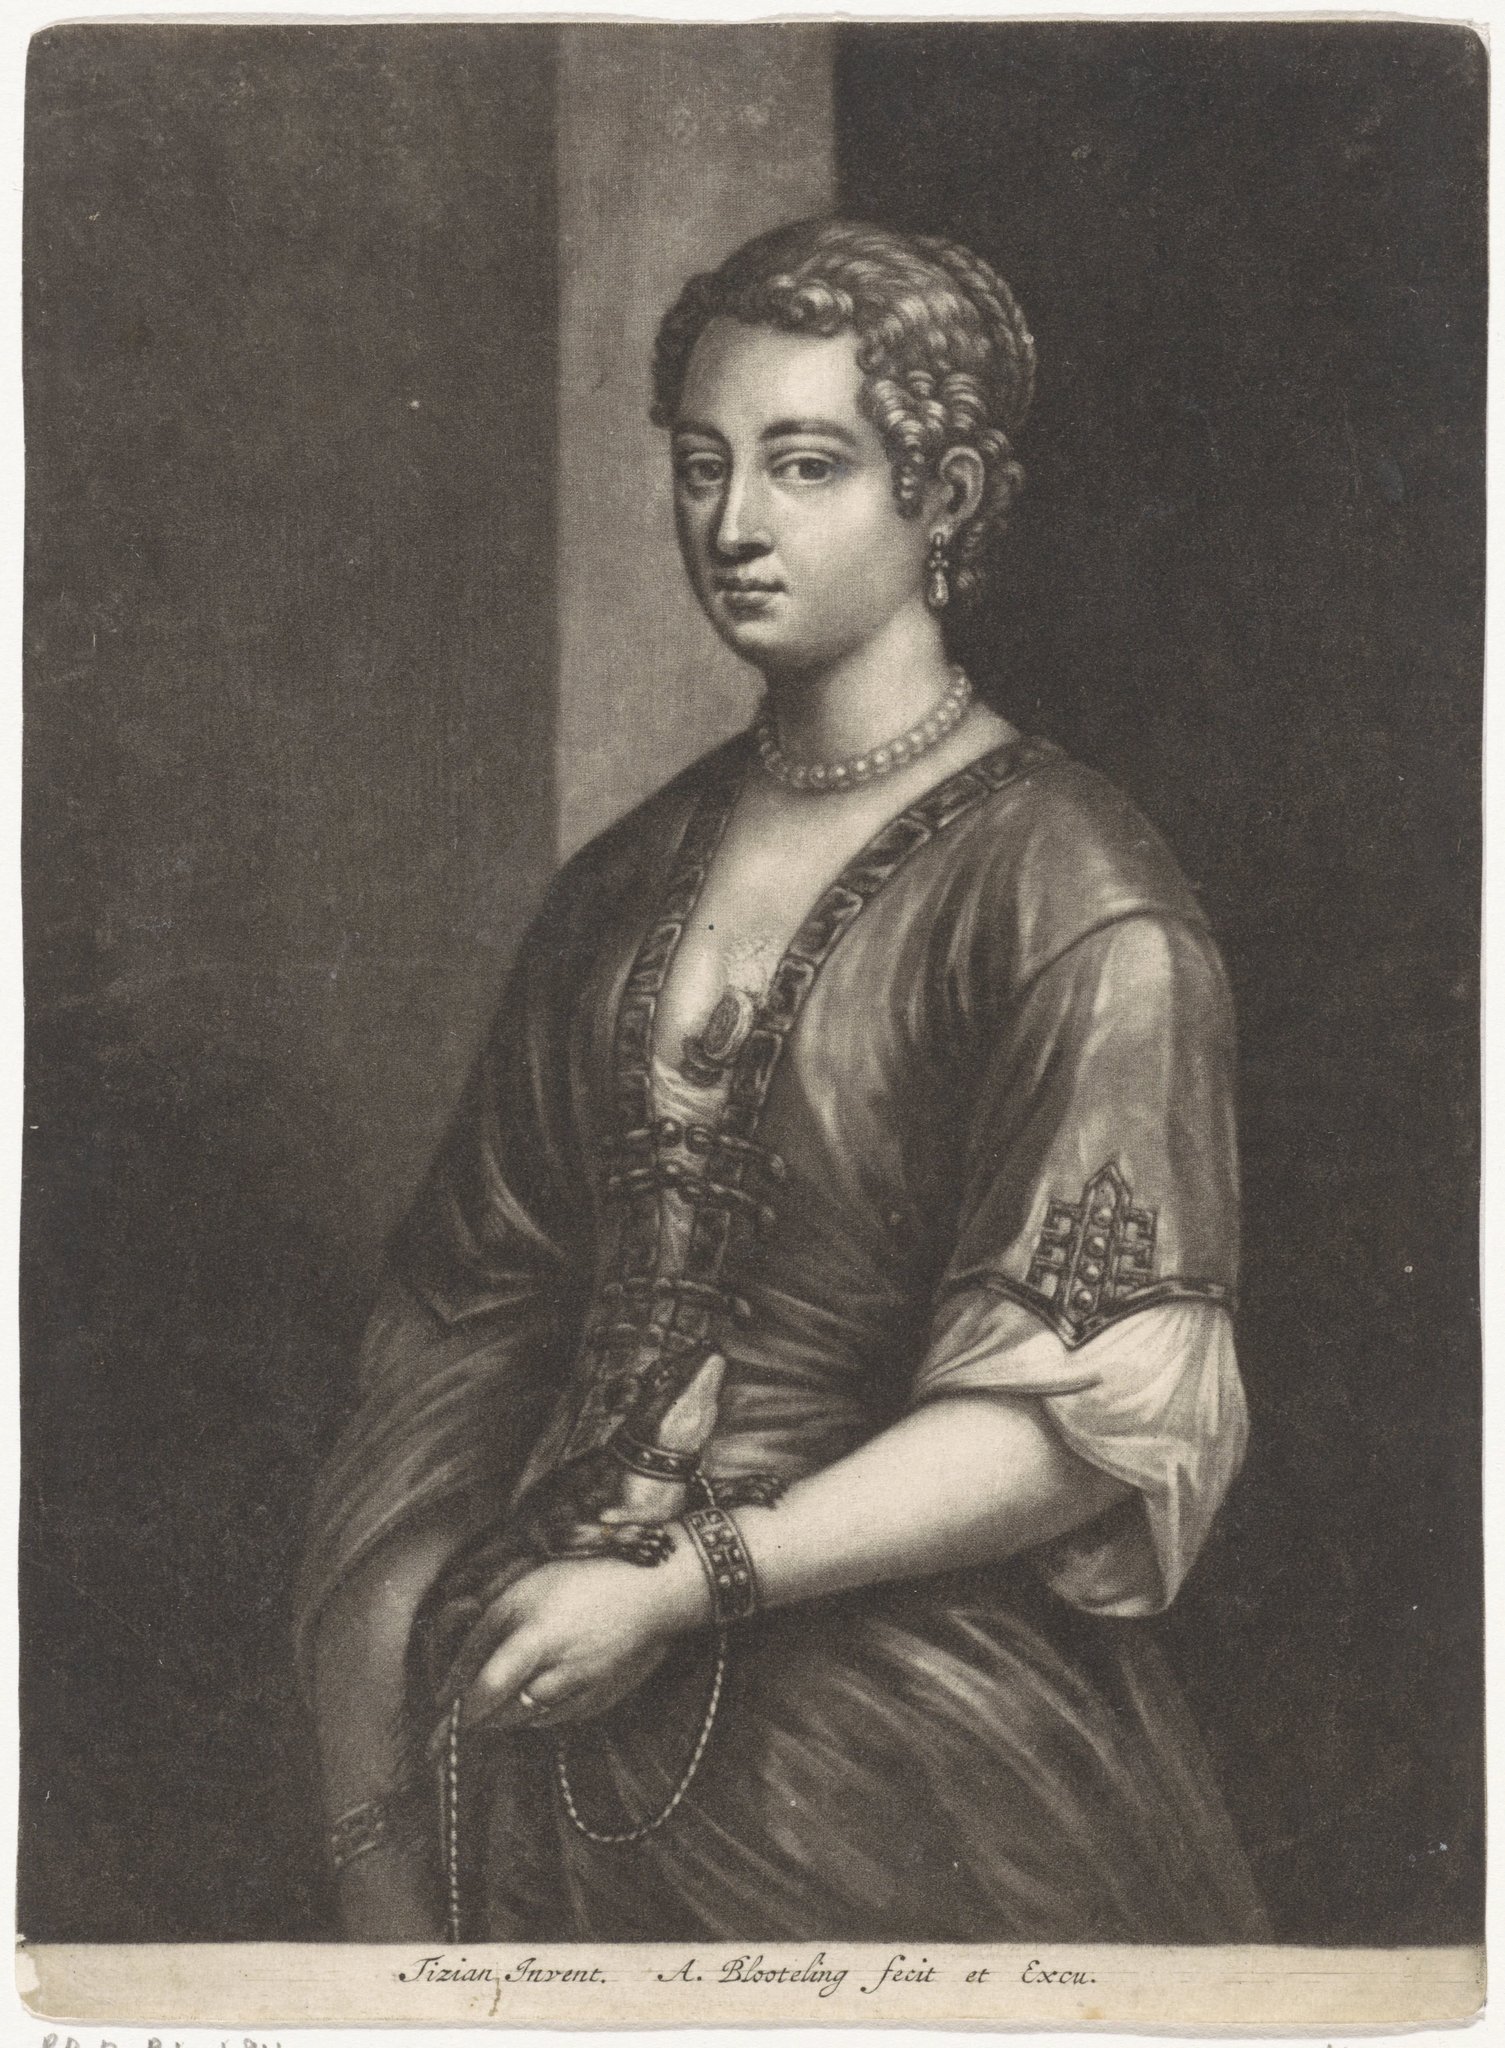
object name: print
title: Jonge vrouw met een hond op de arm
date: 1652-1690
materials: paper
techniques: engraving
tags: dog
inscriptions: collector's mark: Lugt 240